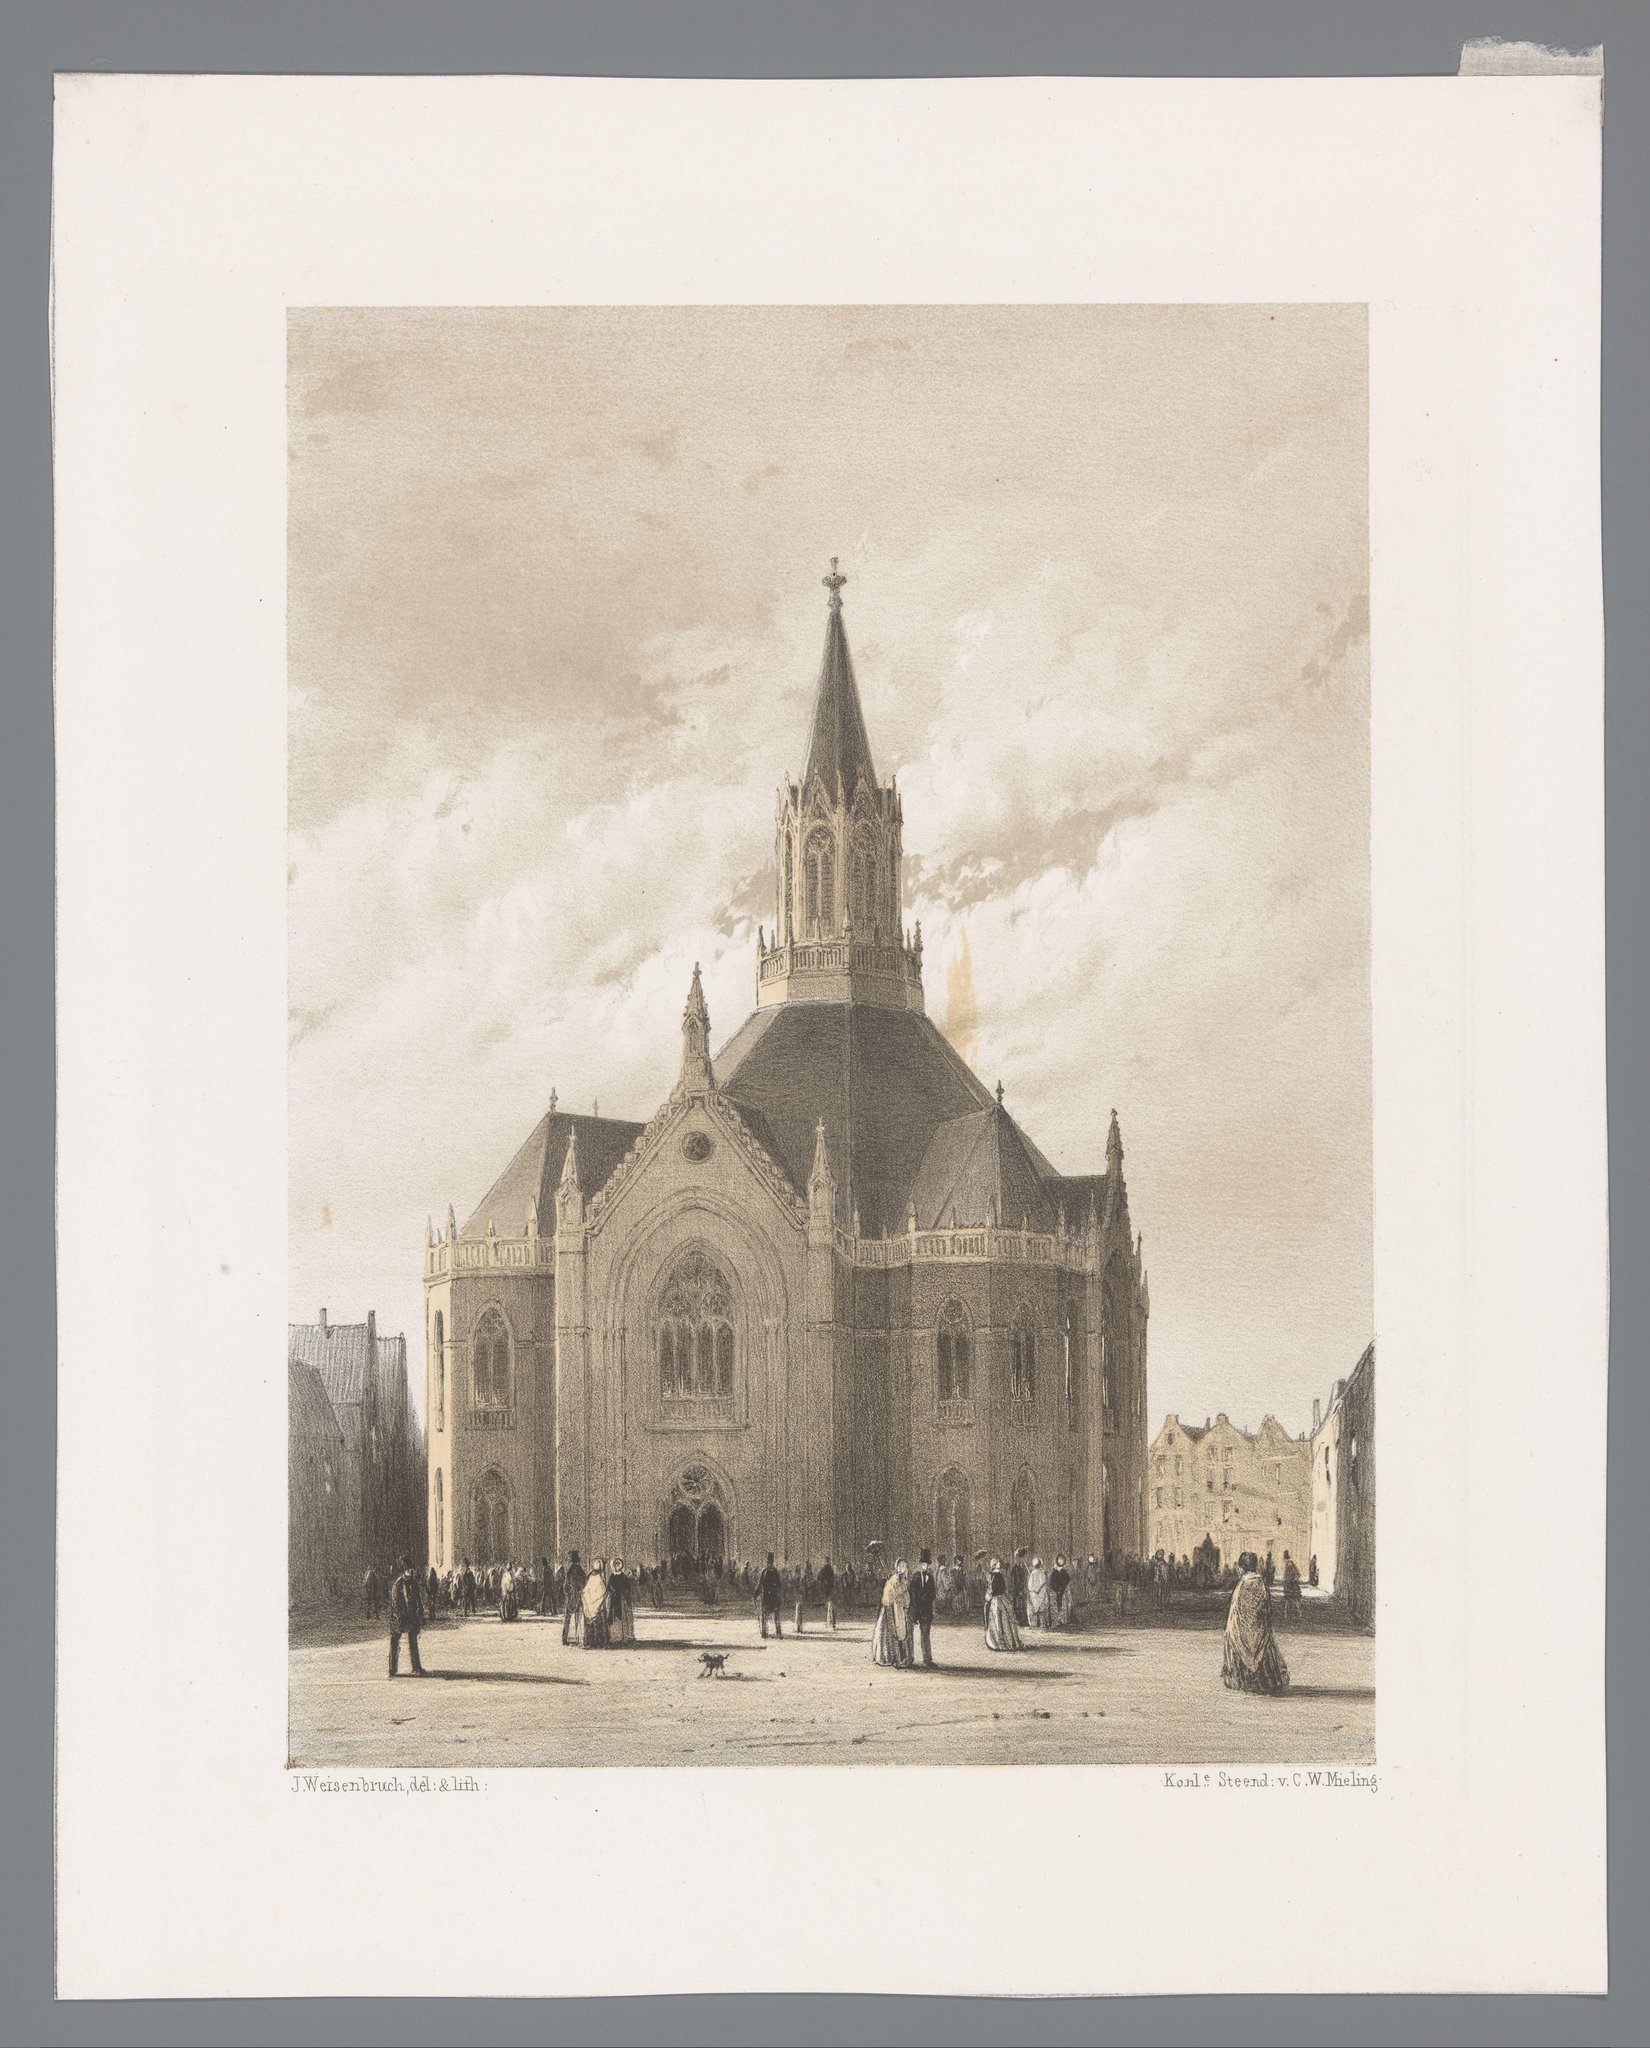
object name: print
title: Gezicht op de Zuiderkerk in Rotterdam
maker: jan weissenbruch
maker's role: painter, print maker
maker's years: 1822-1880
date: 1849-1865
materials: paper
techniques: tone lithography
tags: church (exterior)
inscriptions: collector's mark: Lugt 2228